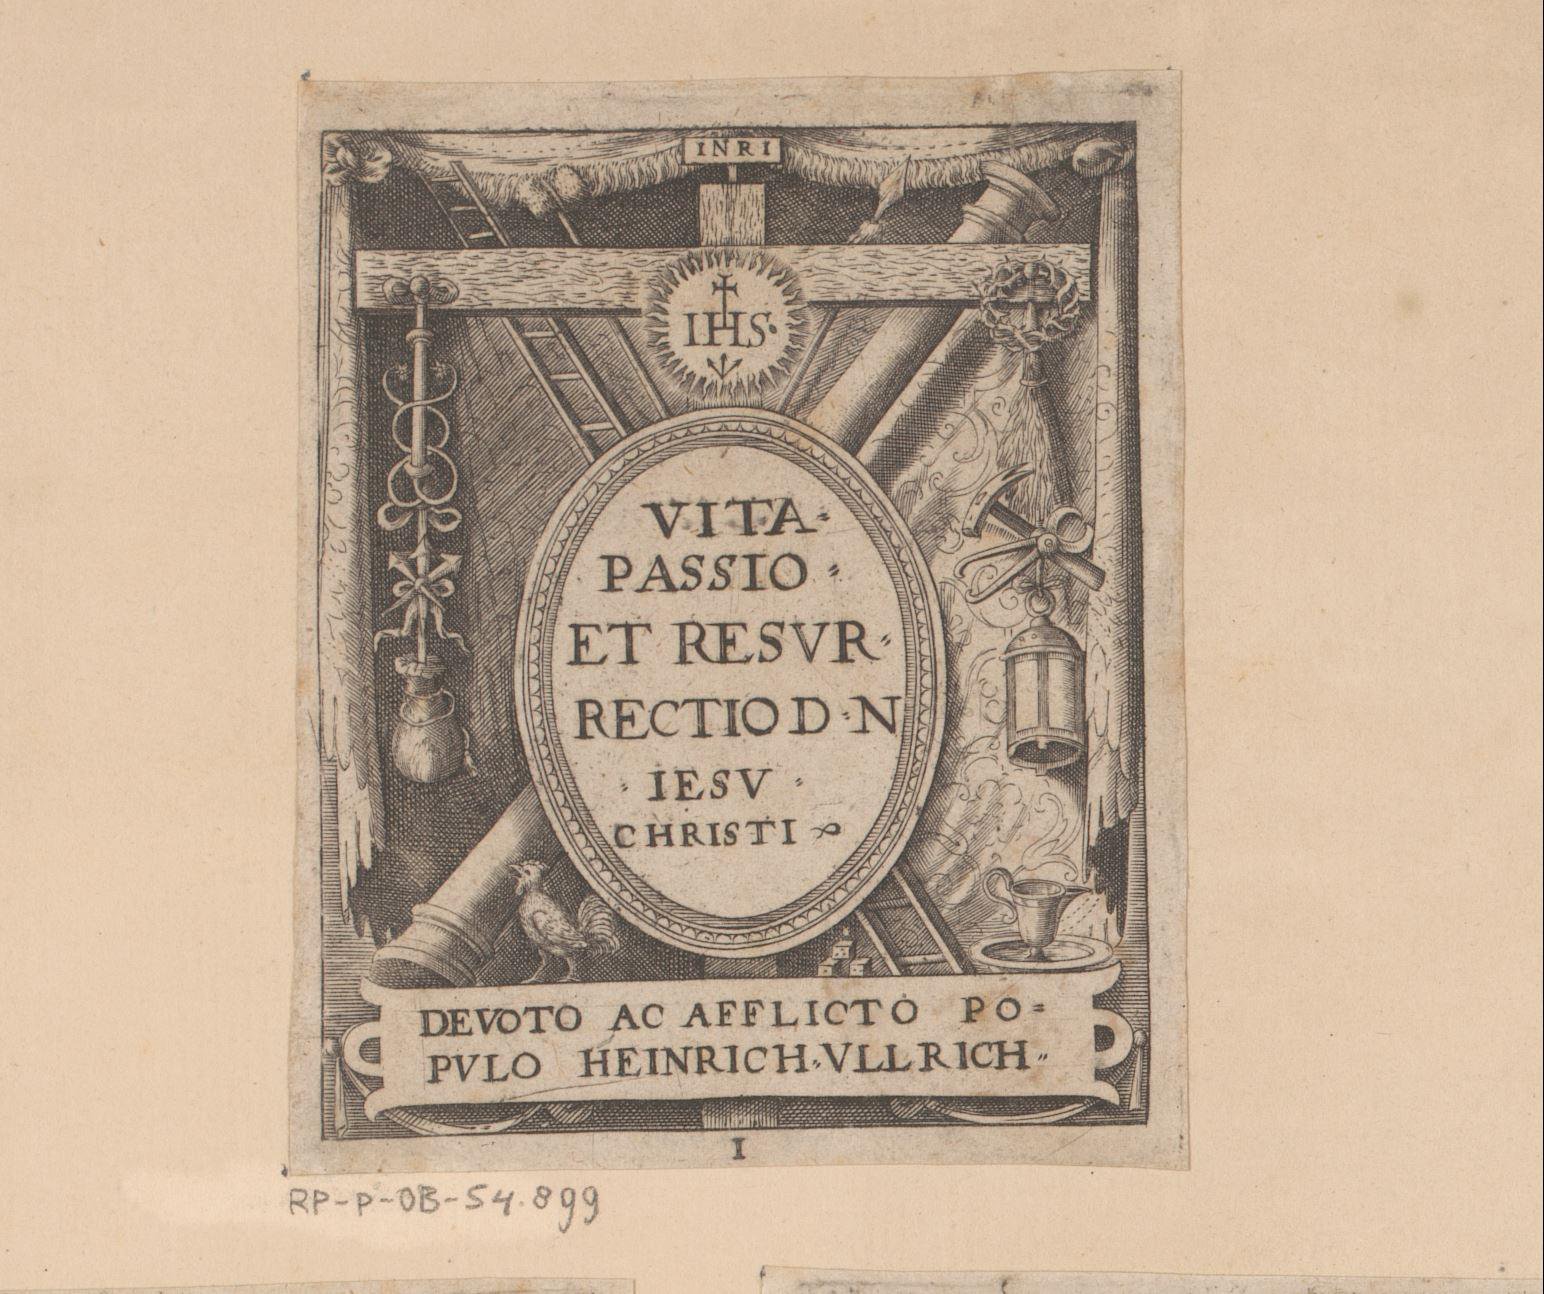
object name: print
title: Vita, passio et resurrectio Jesu Christi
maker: heinrich ulrich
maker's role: draughtsman, painter, print maker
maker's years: 1572-1671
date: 1582-1671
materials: paper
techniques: engraving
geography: germany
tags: 'arma christi'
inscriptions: number: ‘38. - 64.’, collector's mark: Lugt 240